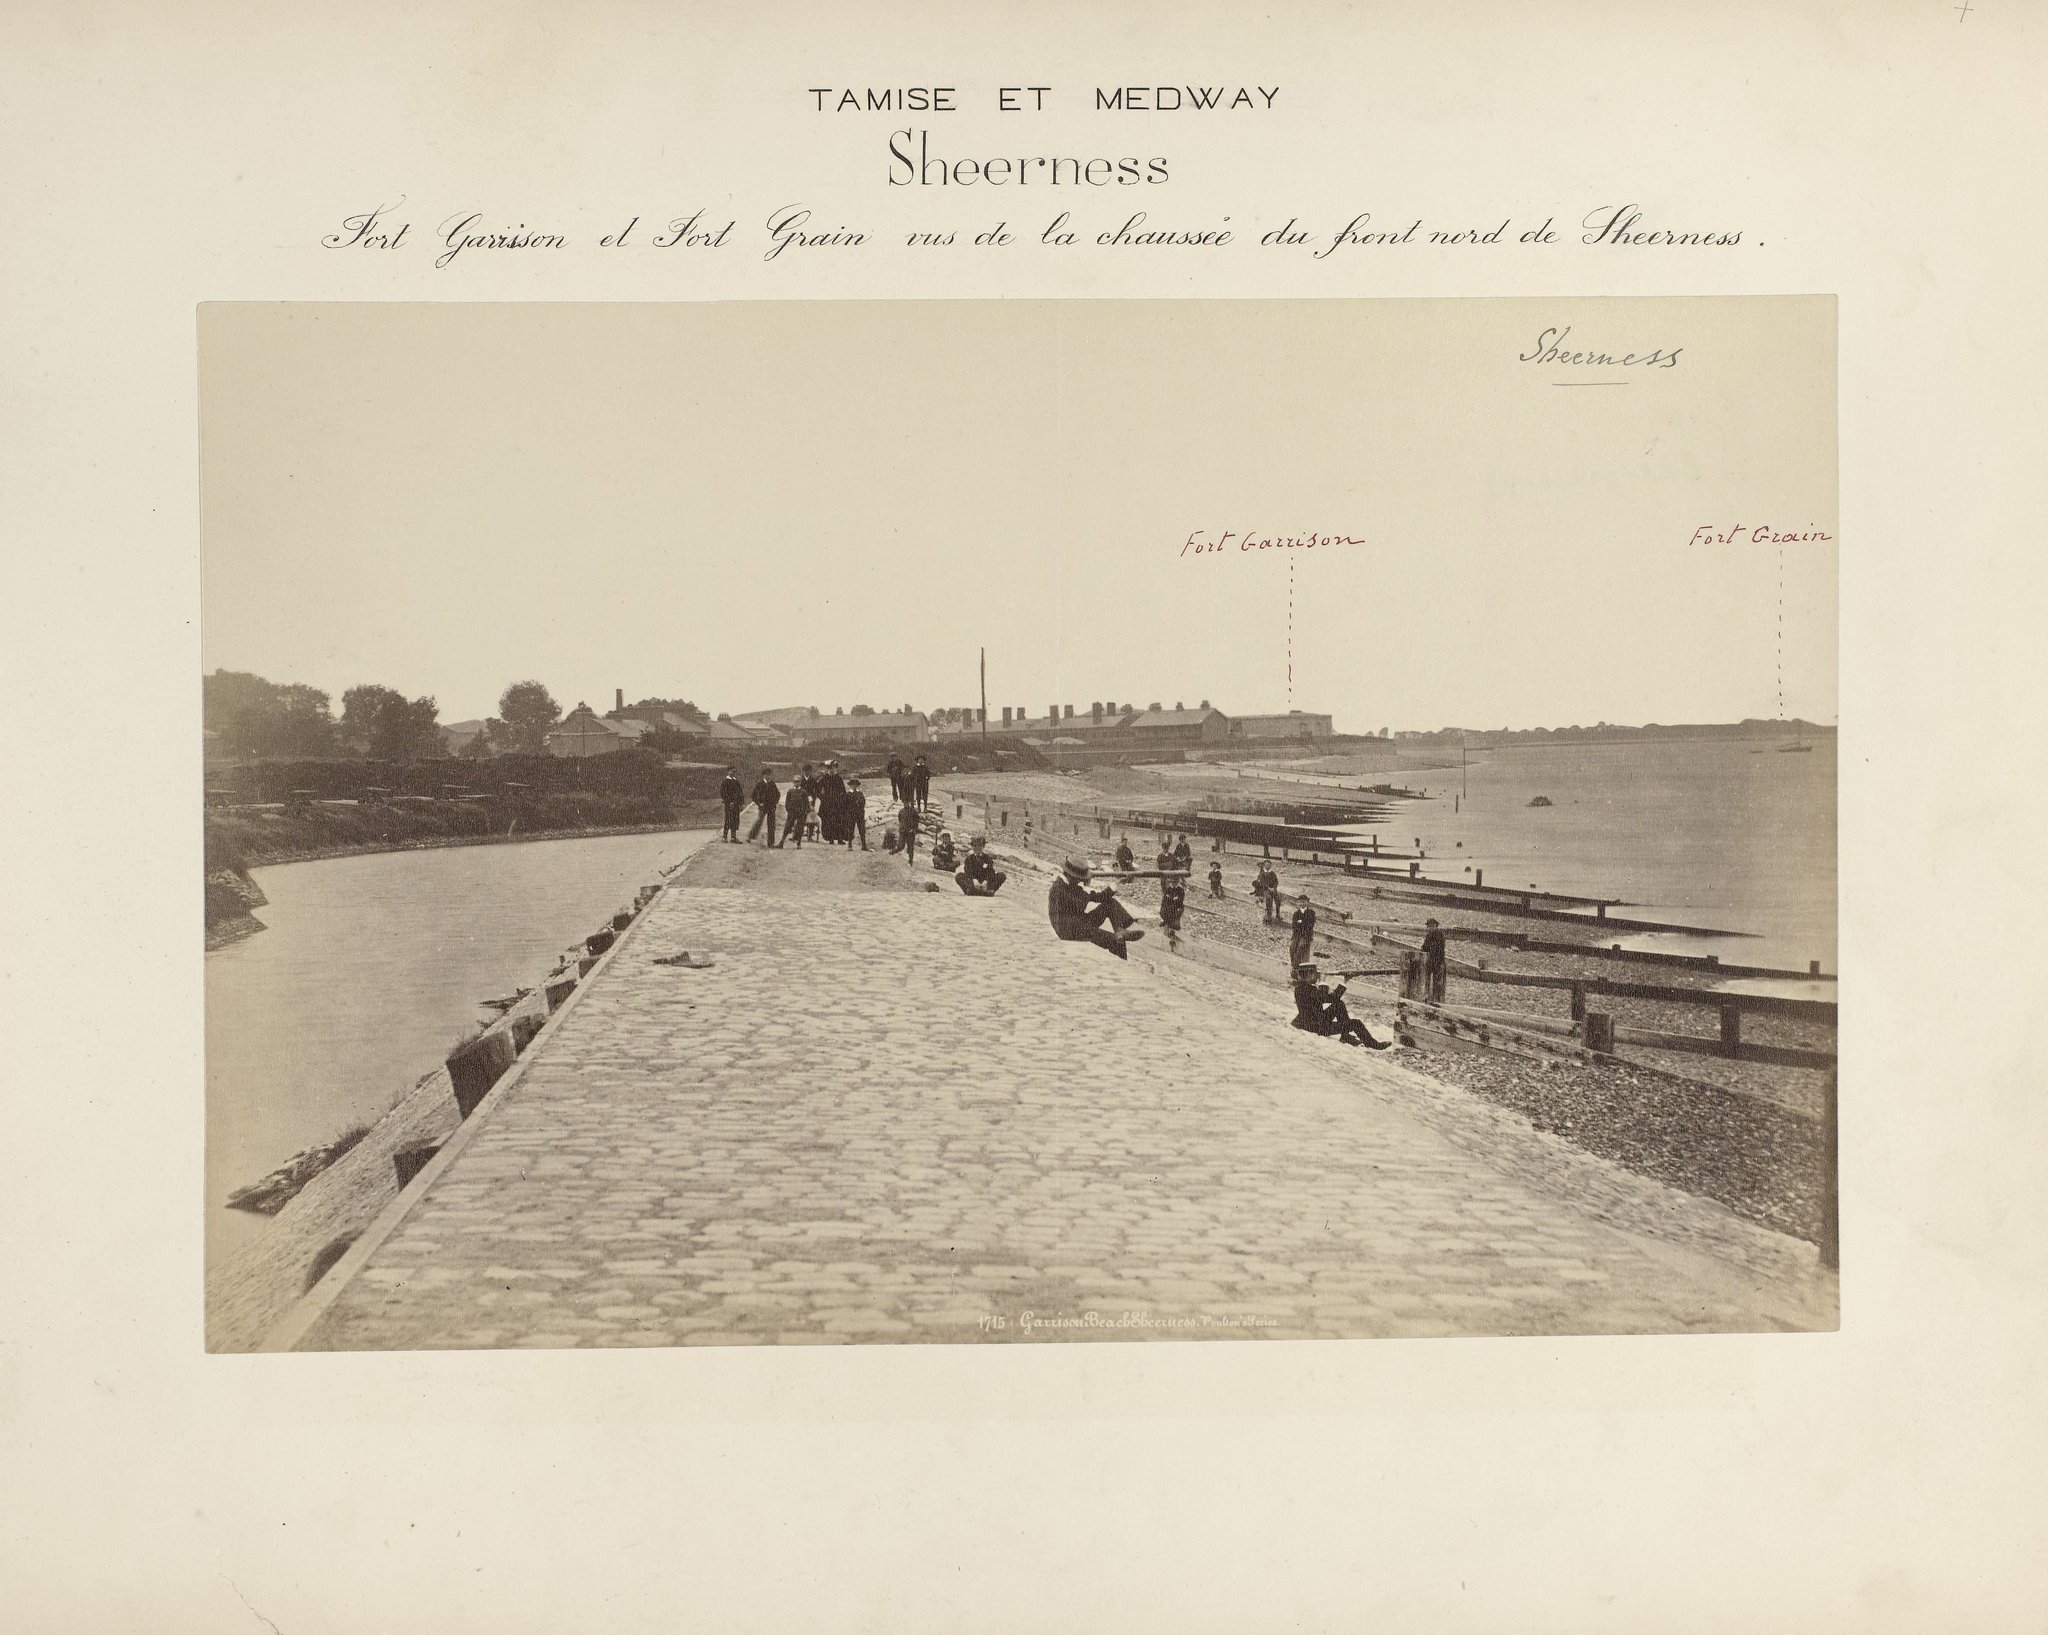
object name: photograph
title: Strand bij Sheerness, met badgasten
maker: poulton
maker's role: fotograaf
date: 1891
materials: cardboard, paper, photographic support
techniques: albumen print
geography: great britain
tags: sheerness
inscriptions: inscription: ‘Sheerness’, inscription: ‘1715 Garrison Beach Sheerness. Poulton's Series’, inscription: ‘TAMISE ET MEDWAY / Sheerness / Fort Garrison et Fort Grain vus de la chaussée du front nord du Sheerness’, annotation: ‘Fort Garrison // Fort Grain’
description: Foto uit een album met 35 topografische foto's van Britse kustplaatsen, waarop in pen militaire verdedigingswerken zijn aangegeven door een Franse militair.